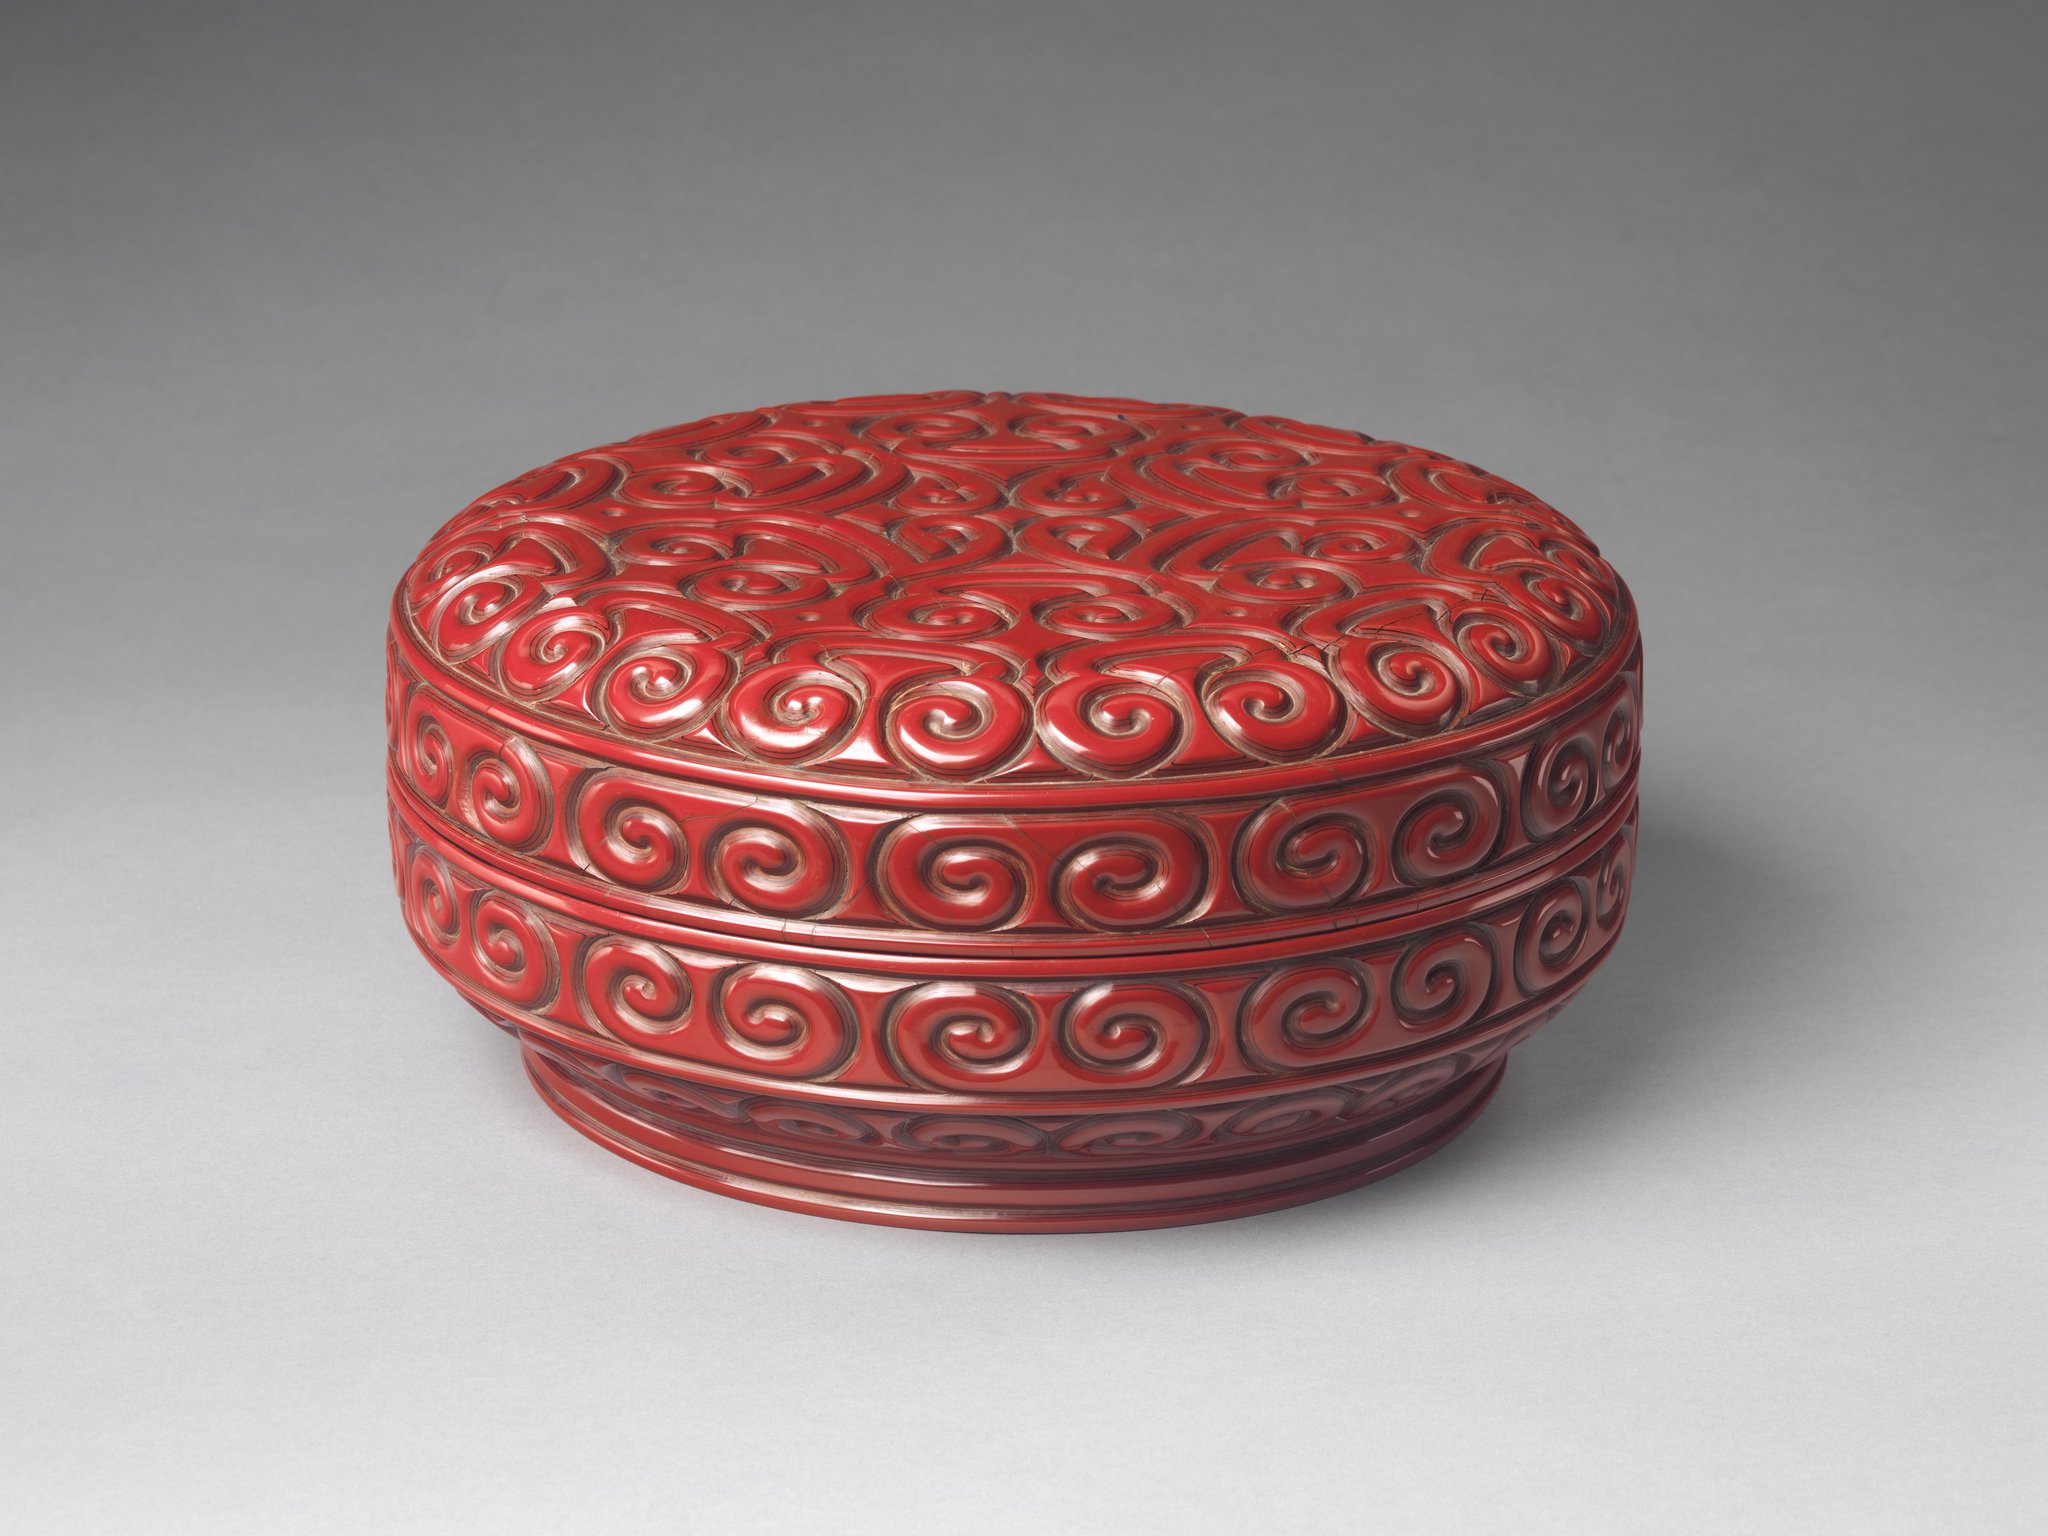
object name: box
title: Box with pommel scroll design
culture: chinese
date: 1351-1400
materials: lacquer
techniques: carving